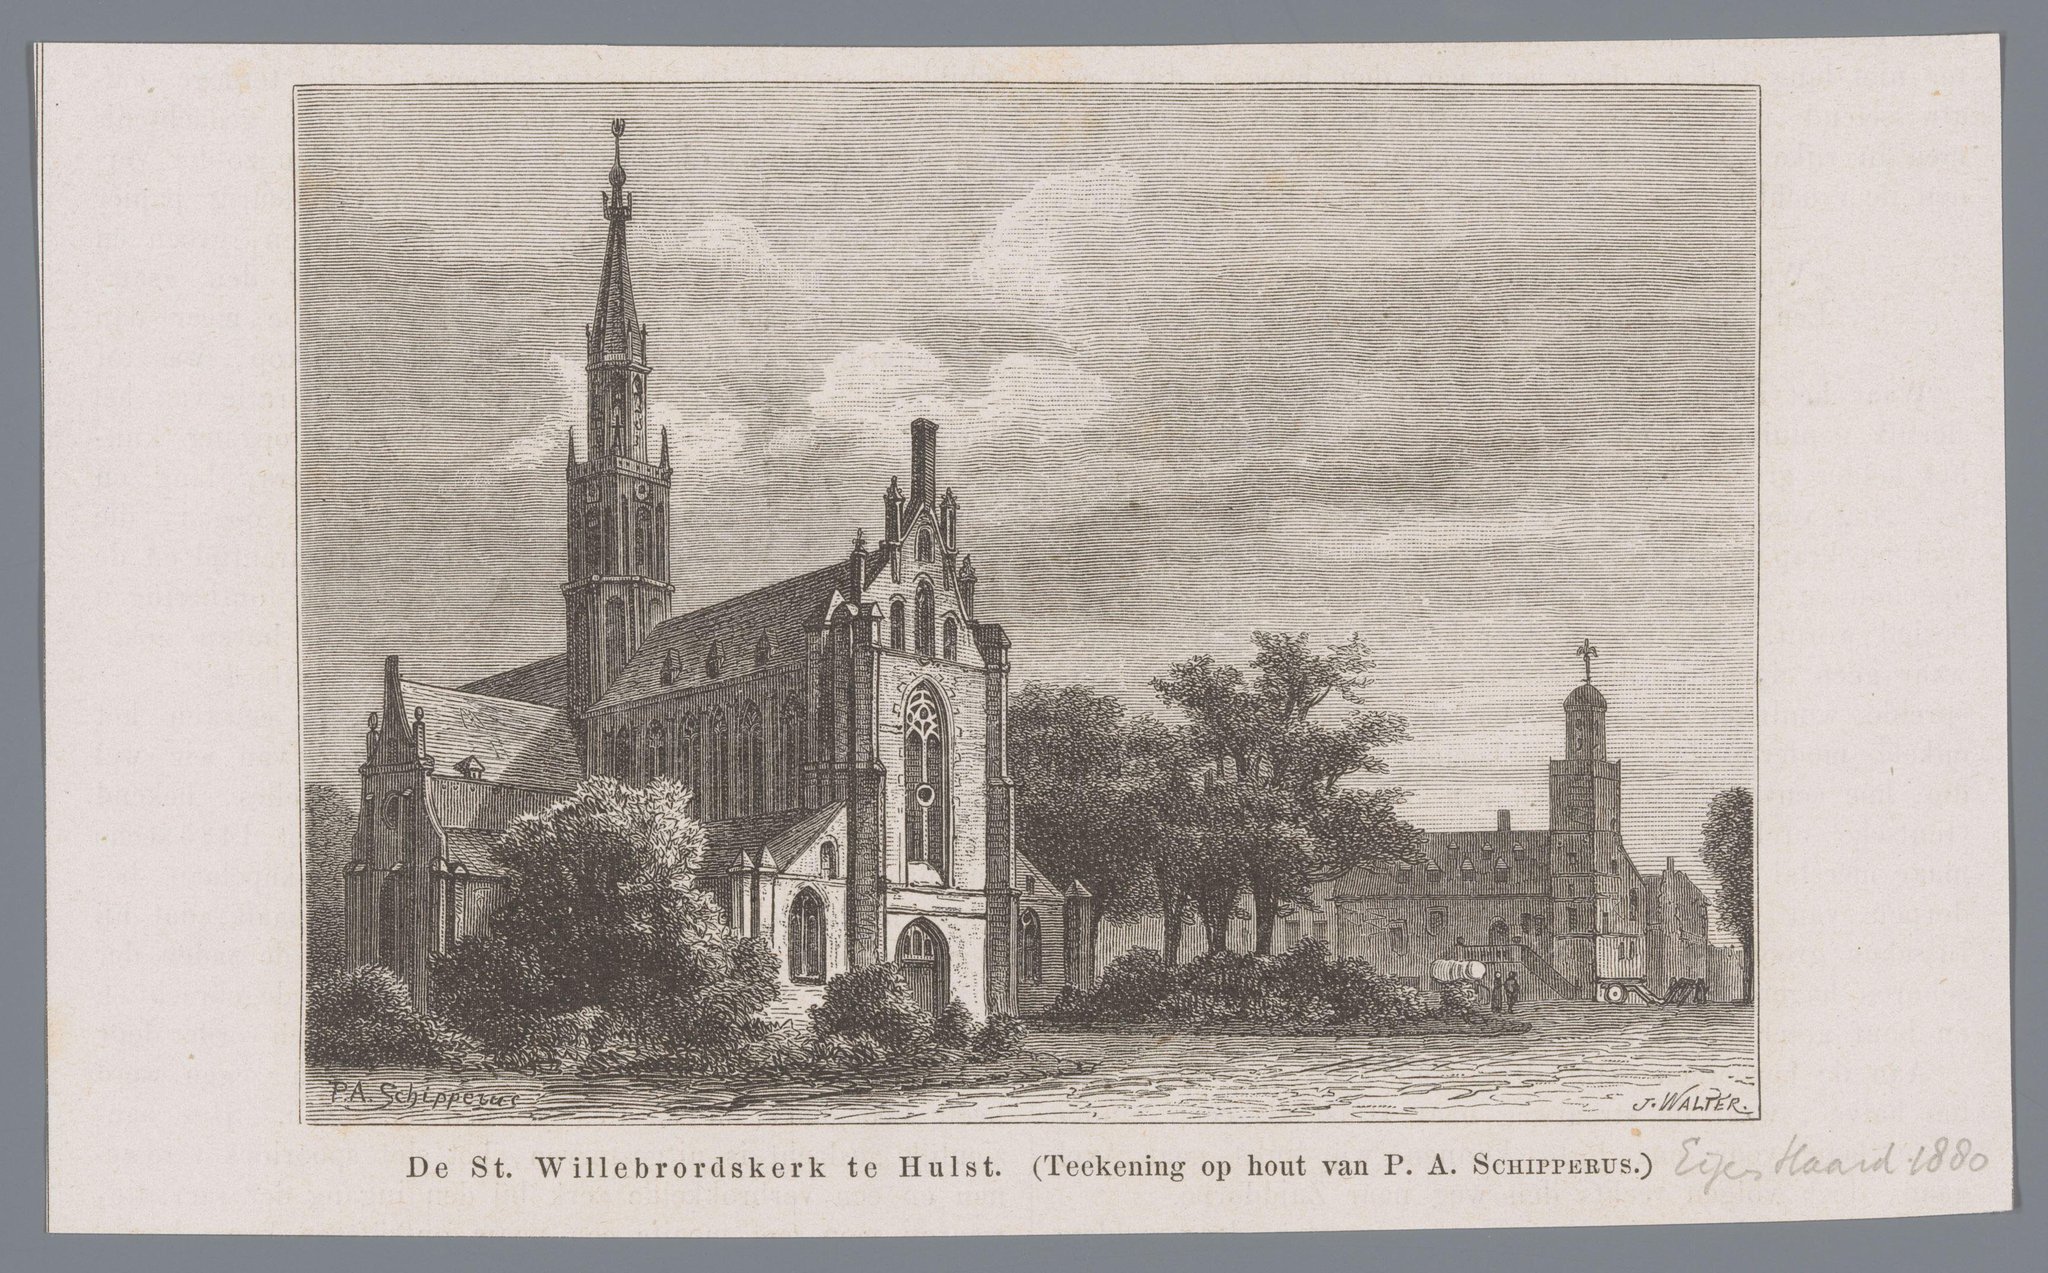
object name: print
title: Sint-Willibrordusbasiliek te Hulst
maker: john walter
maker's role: publisher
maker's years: -1803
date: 1880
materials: paper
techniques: letterpress printing, engraving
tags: city-view, and landscape with man-made constructions